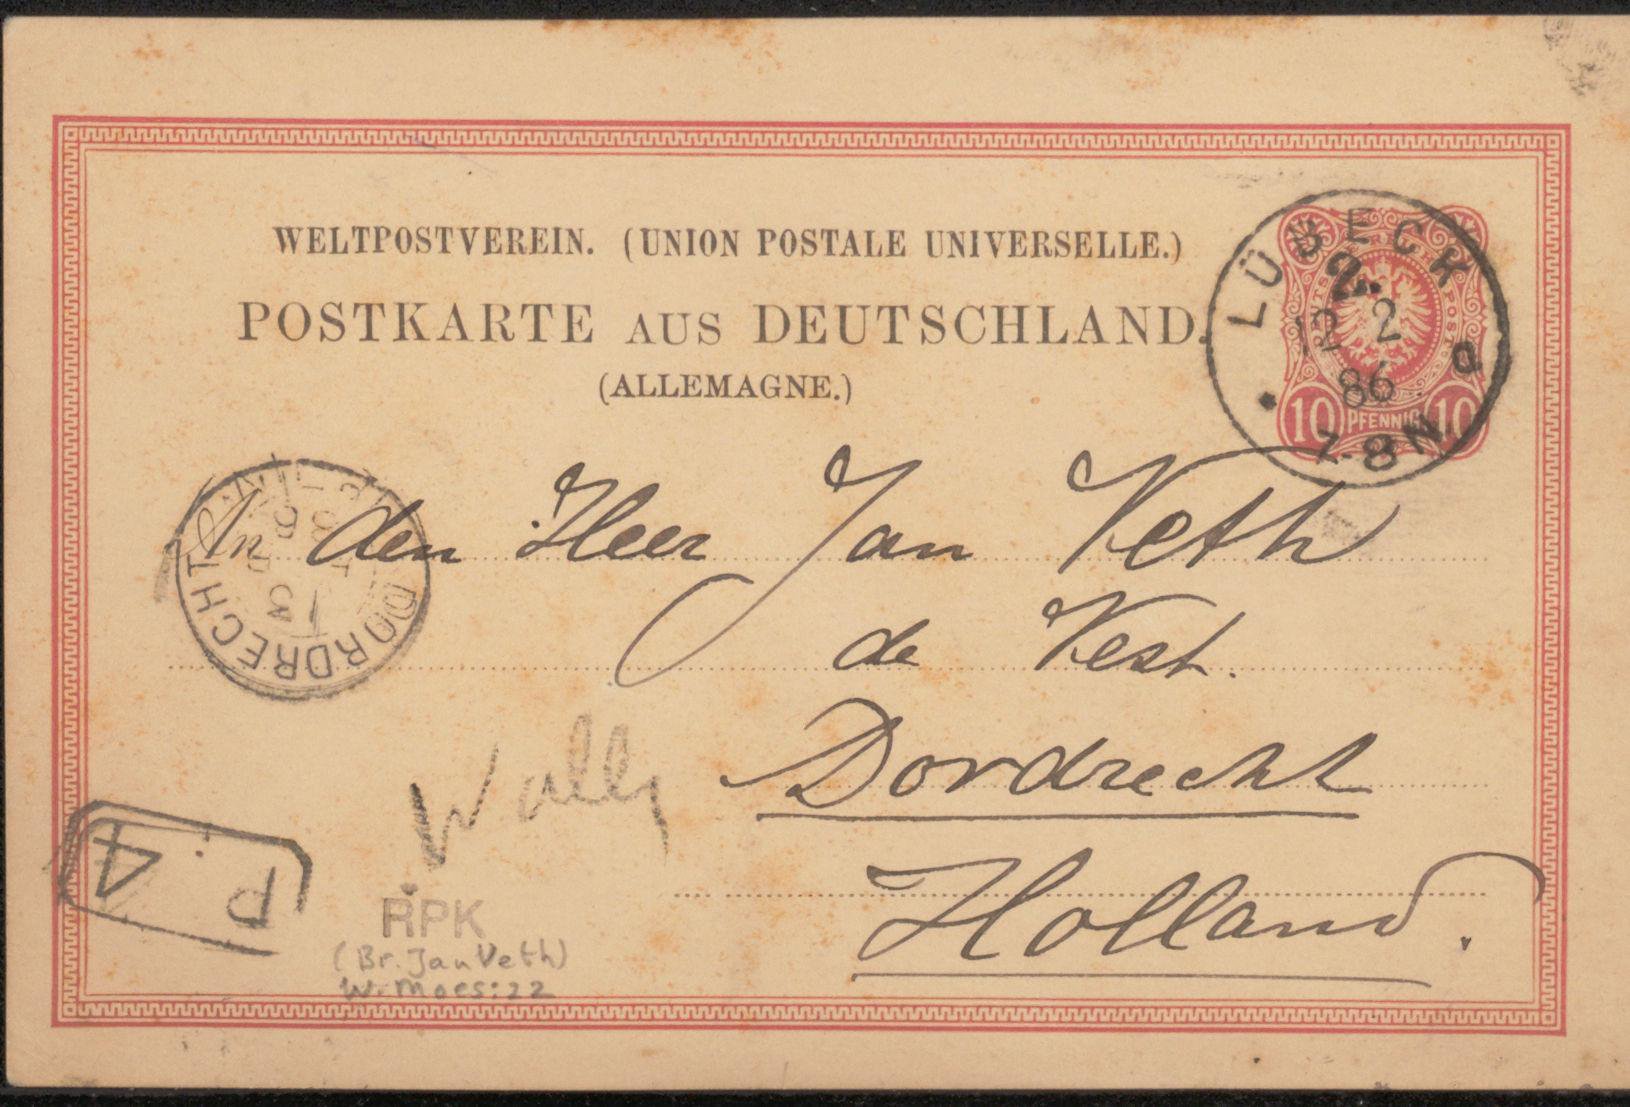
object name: postcard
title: Briefkaart aan Jan Veth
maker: wally moes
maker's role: draughtsman, print maker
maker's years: 1856-1918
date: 1886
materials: cardboard, ink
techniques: pen, writing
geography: lübeck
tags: dordrecht, painter, designer, jan veth, martinus mouton, the graphic arts, historical persons (portraits and scenes from the life), brussels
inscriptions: collector's mark: ‘RPK’